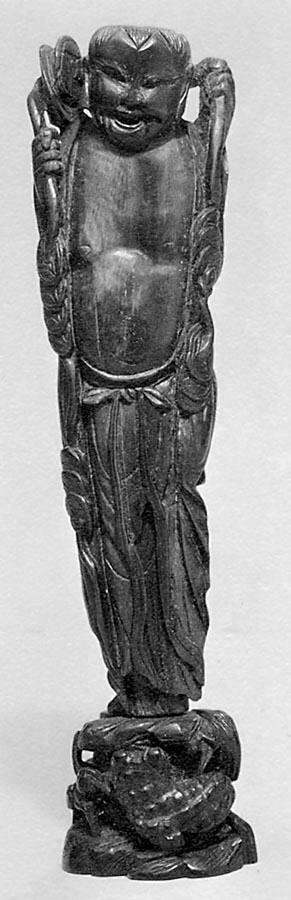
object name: statuette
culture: chinese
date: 1767-1800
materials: ivory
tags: men